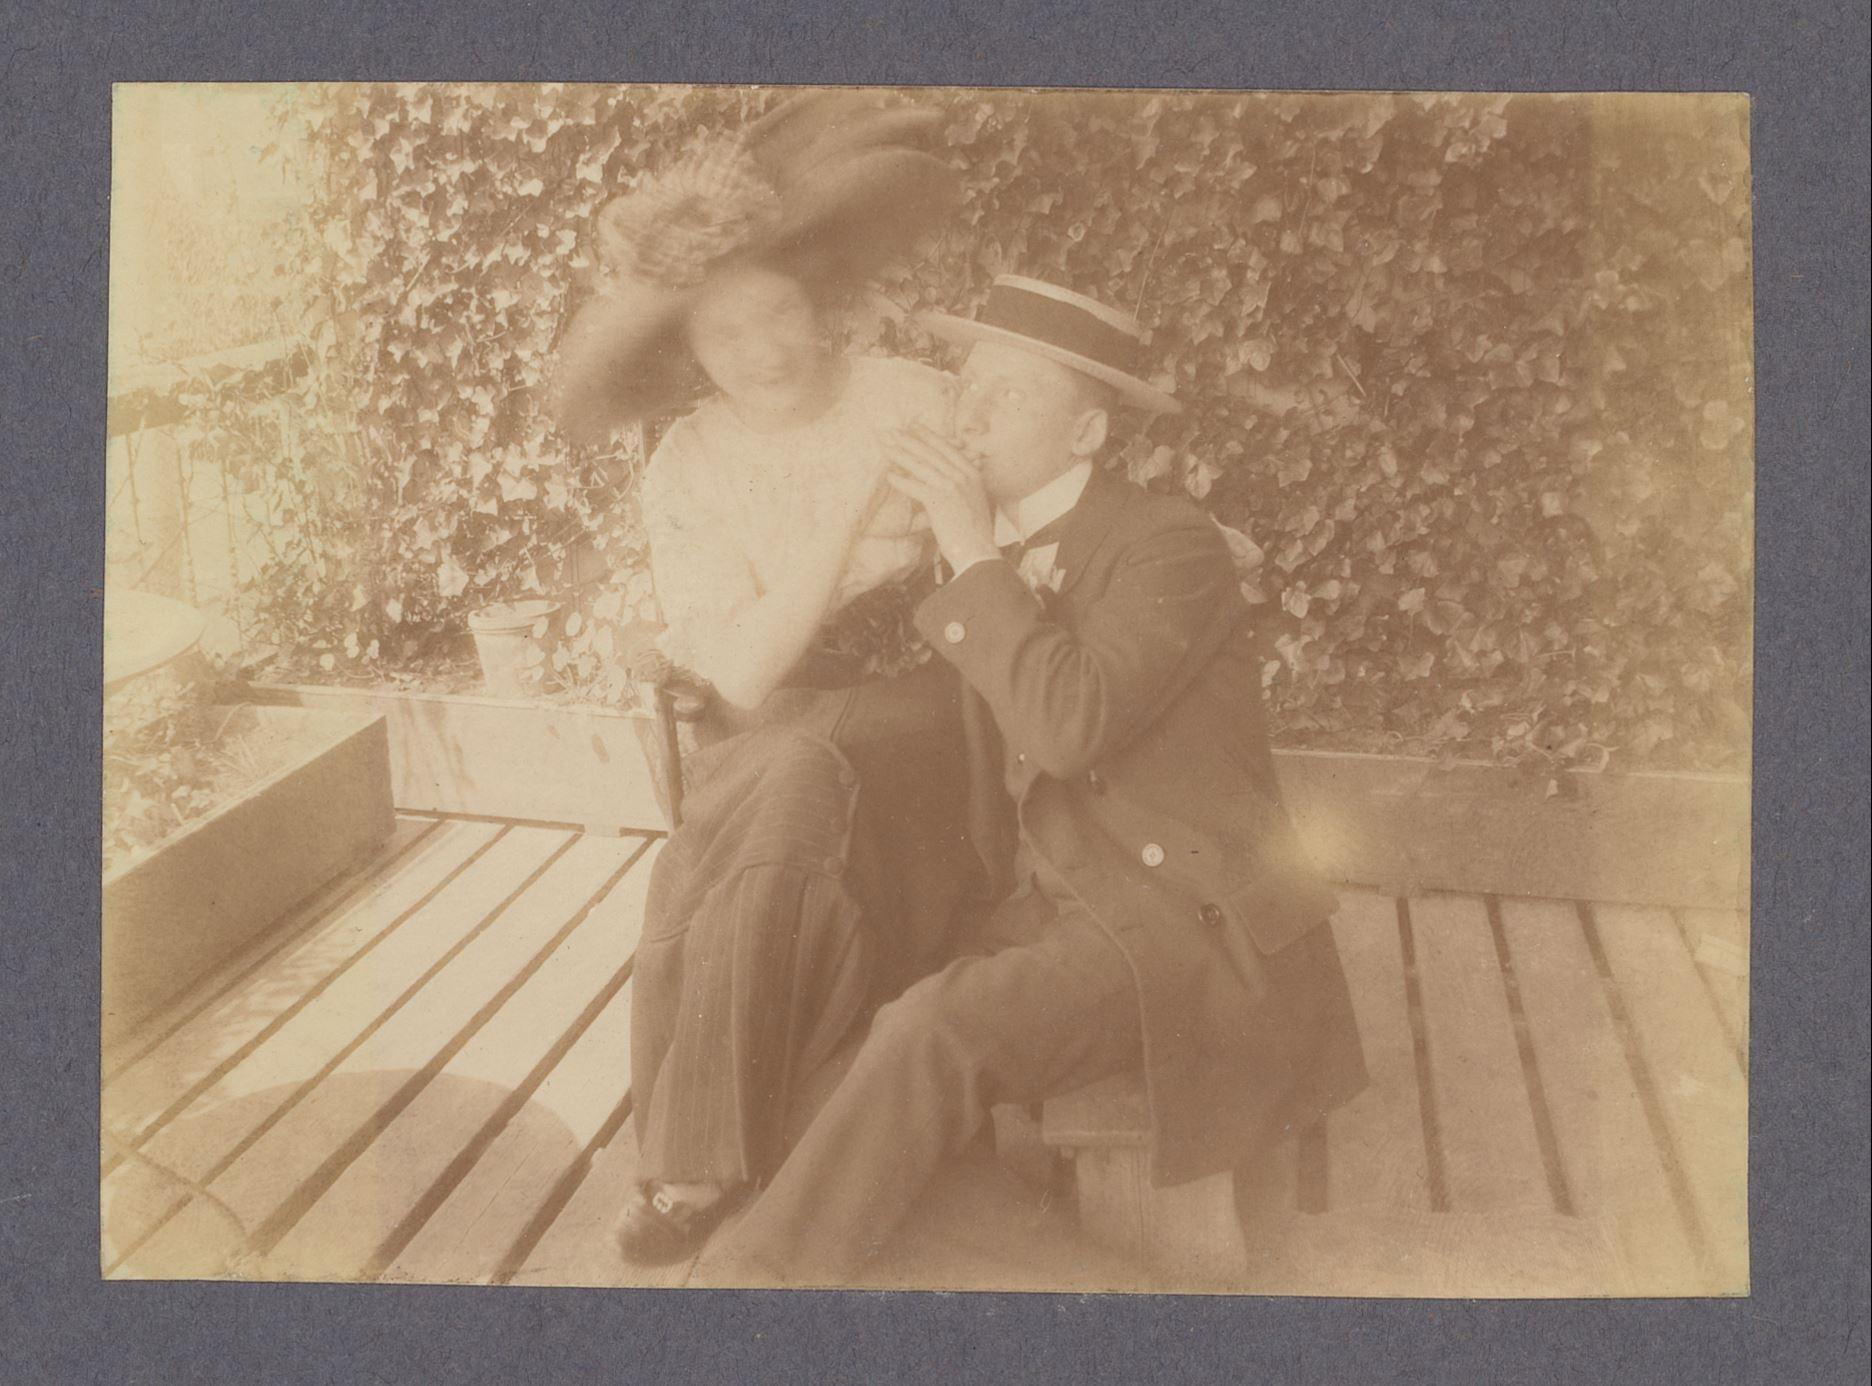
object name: photograph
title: David Vermeulen en een vrouw op het balkon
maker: cornelis johannes lodewicus vermeulen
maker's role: fotograaf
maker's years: 1861-1936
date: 1900-1925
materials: photographic support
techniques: gelatin silver print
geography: the hague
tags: adult woman, adult man, kissing the hand (lovers)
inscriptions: annotation: ‘David’